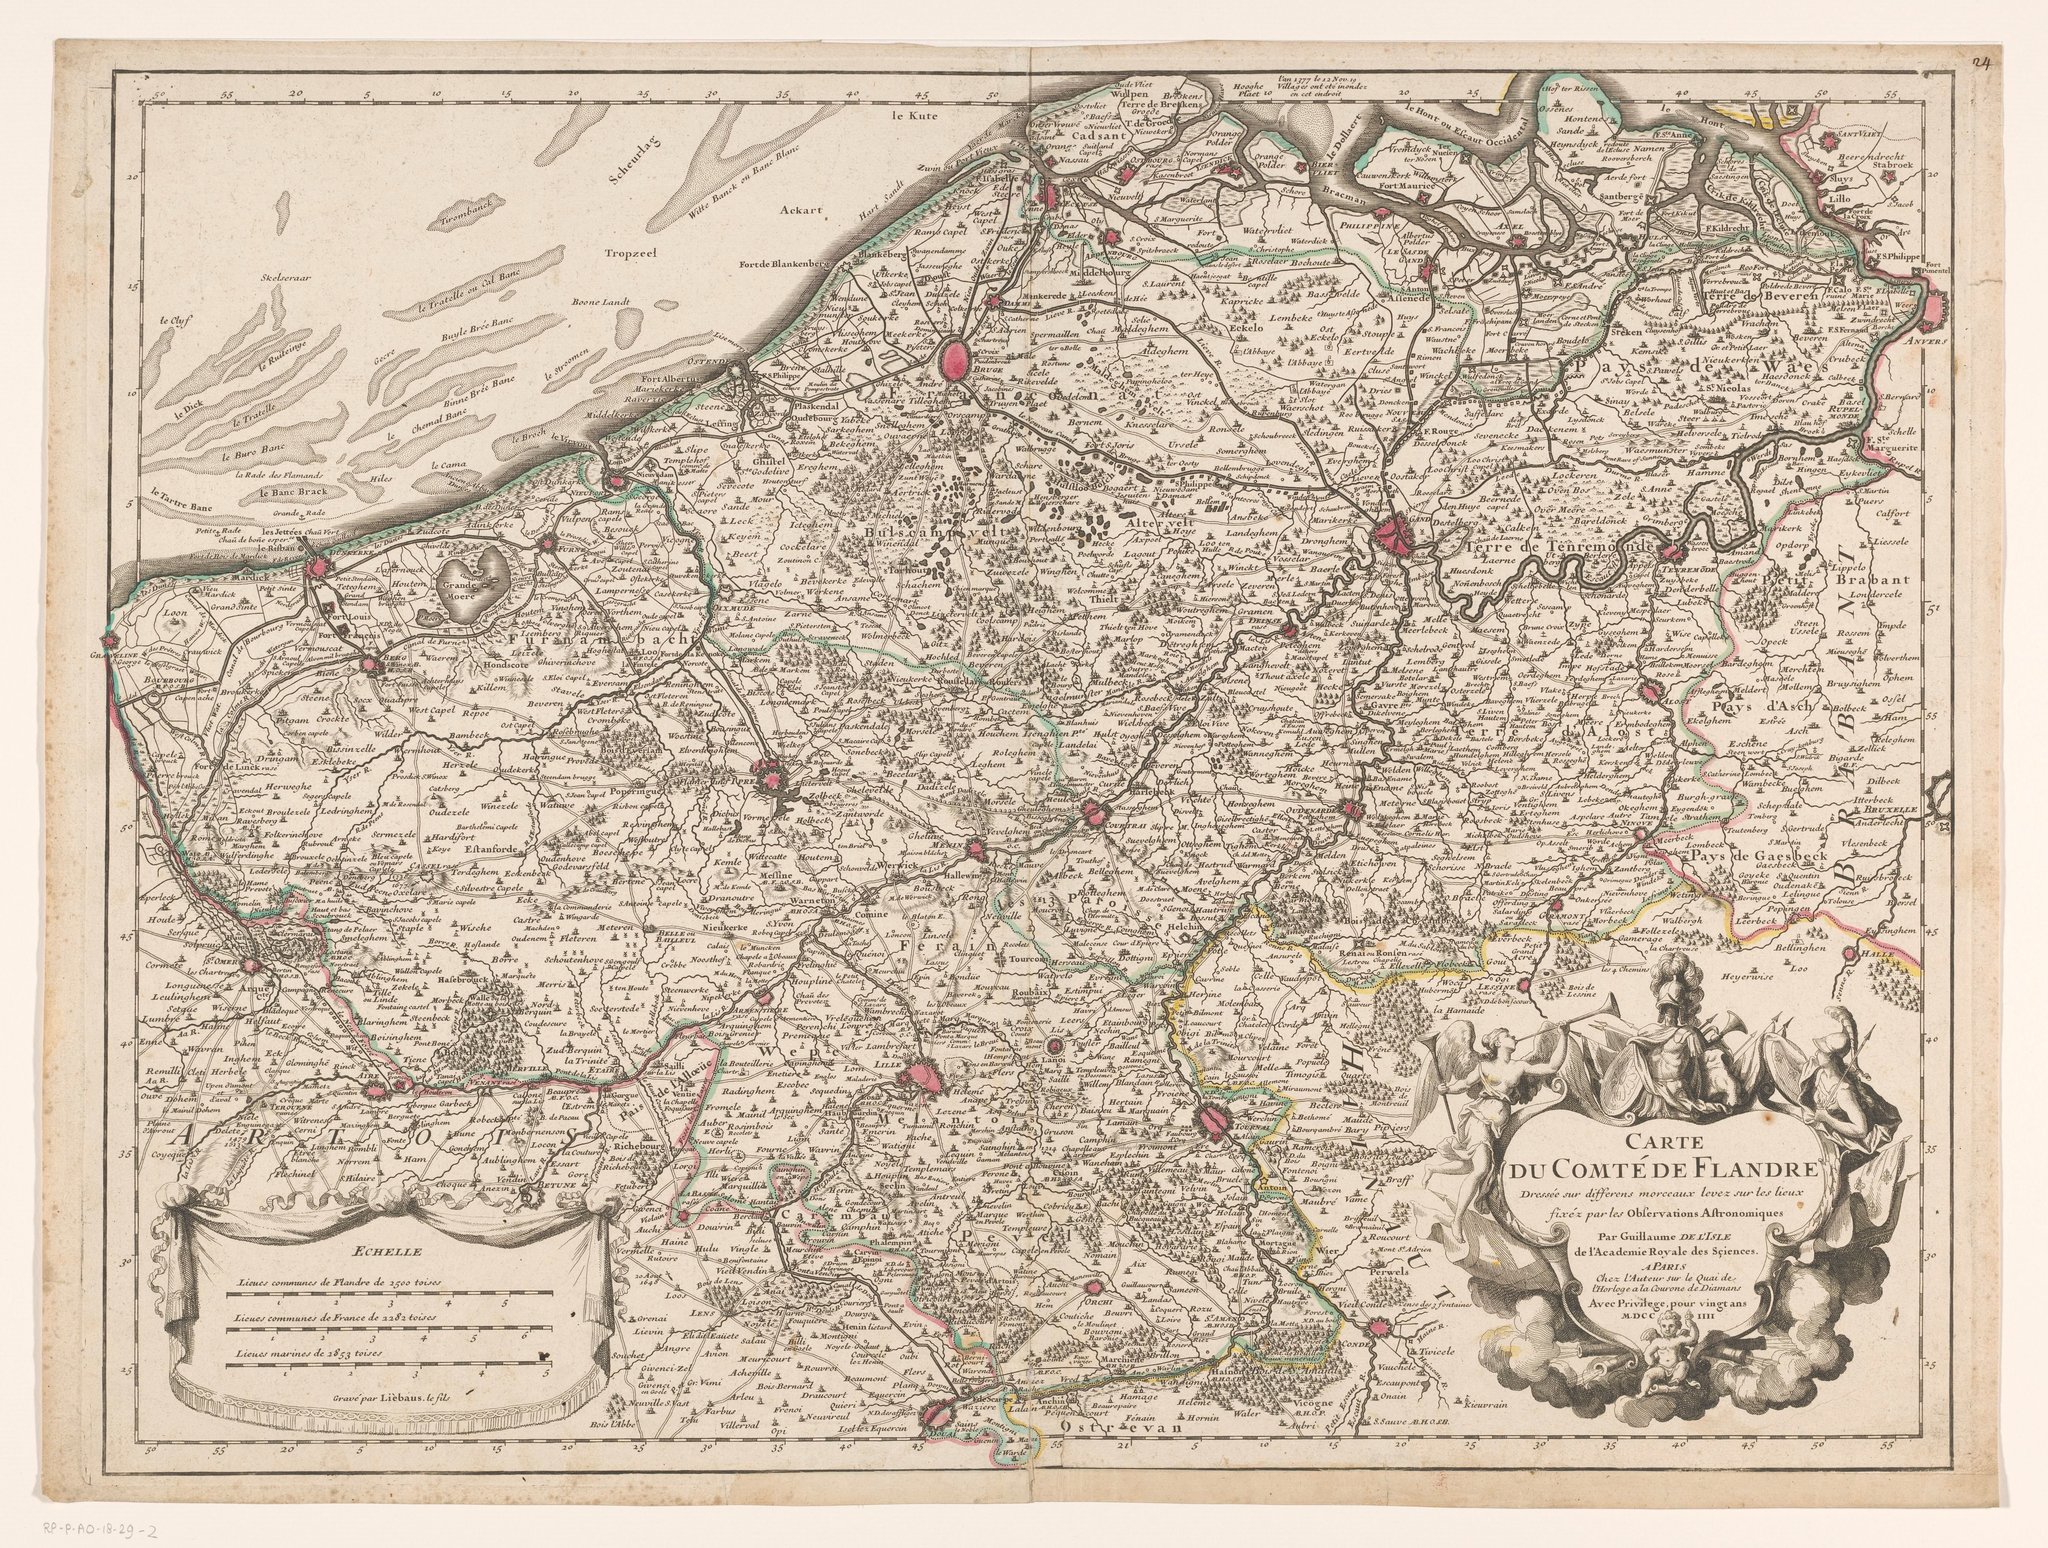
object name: print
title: Kaart van het graafschap Vlaanderen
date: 1704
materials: paper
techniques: engraving, etching, hand coloring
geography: paris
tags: maps of separate countries or regions, (story of) minerva (pallas, athena), fame; 'fama', 'fama buona', 'fama chiara' (ripa)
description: Kaart van het graafschap Vlaanderen. Rechtsonder de titelcartouche met links een personificatie van Faam en rechts Minerva. Linksonder een cartouche met drie schaalstokken: Lieues communes d Flandre de 2500 toises / Lieues communes de France de 2282 toises / Lieues marines de 2853 toises. De kaart is voorzien van een gradenverdeling langs de randen.